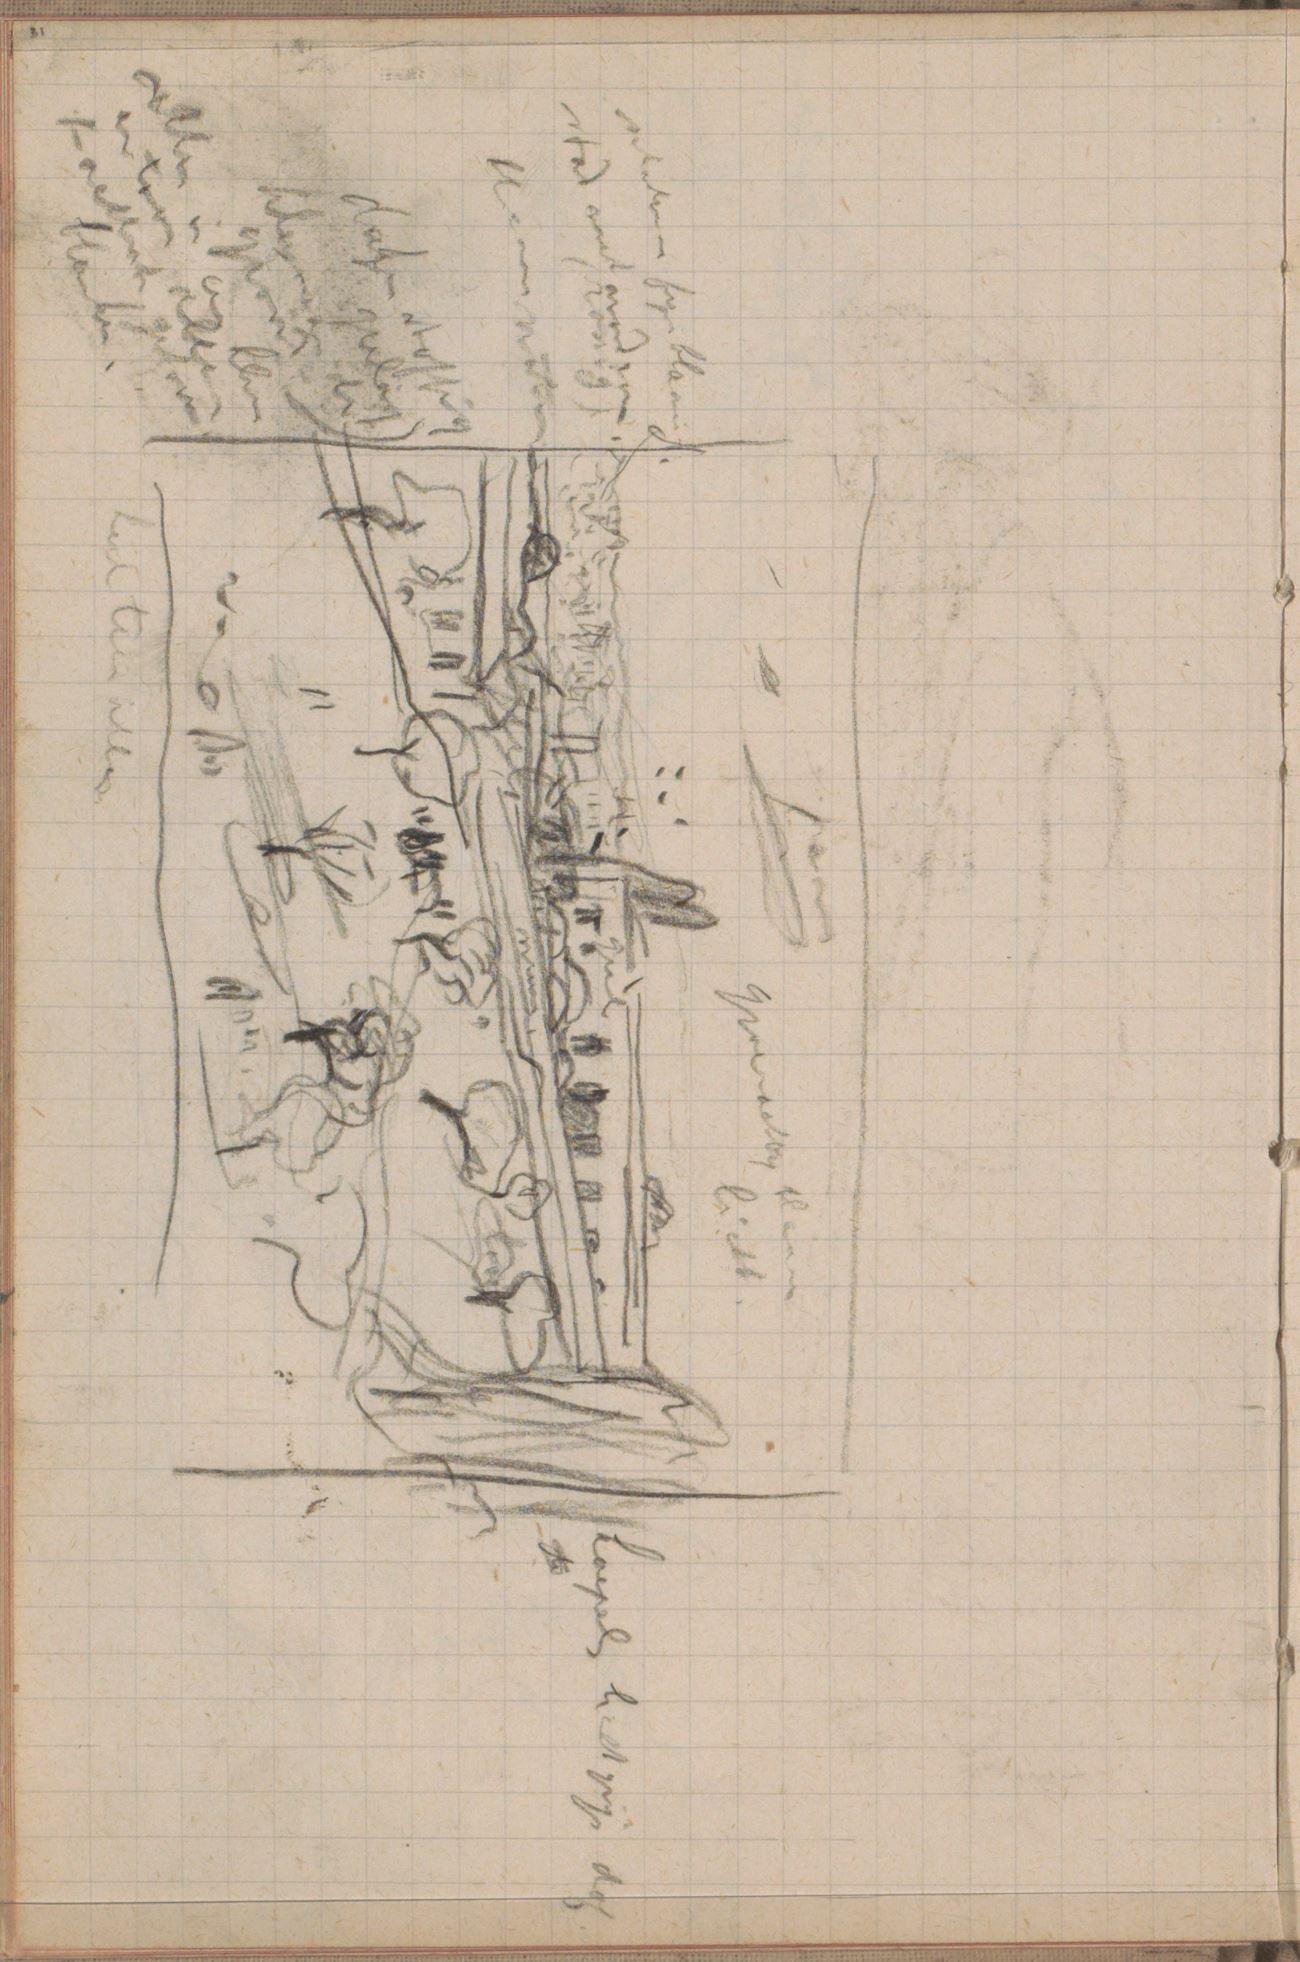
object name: sketchbook leaf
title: Landschap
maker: marius bauer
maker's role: draughtsman, print maker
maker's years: 1867-1932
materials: chalk, paper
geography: istanbul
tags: trees, landscapes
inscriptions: kleurnotitie, handgeschreven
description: Met bomen en gebouwen. Pagina 31 uit een schetsboek met 51 bladen.